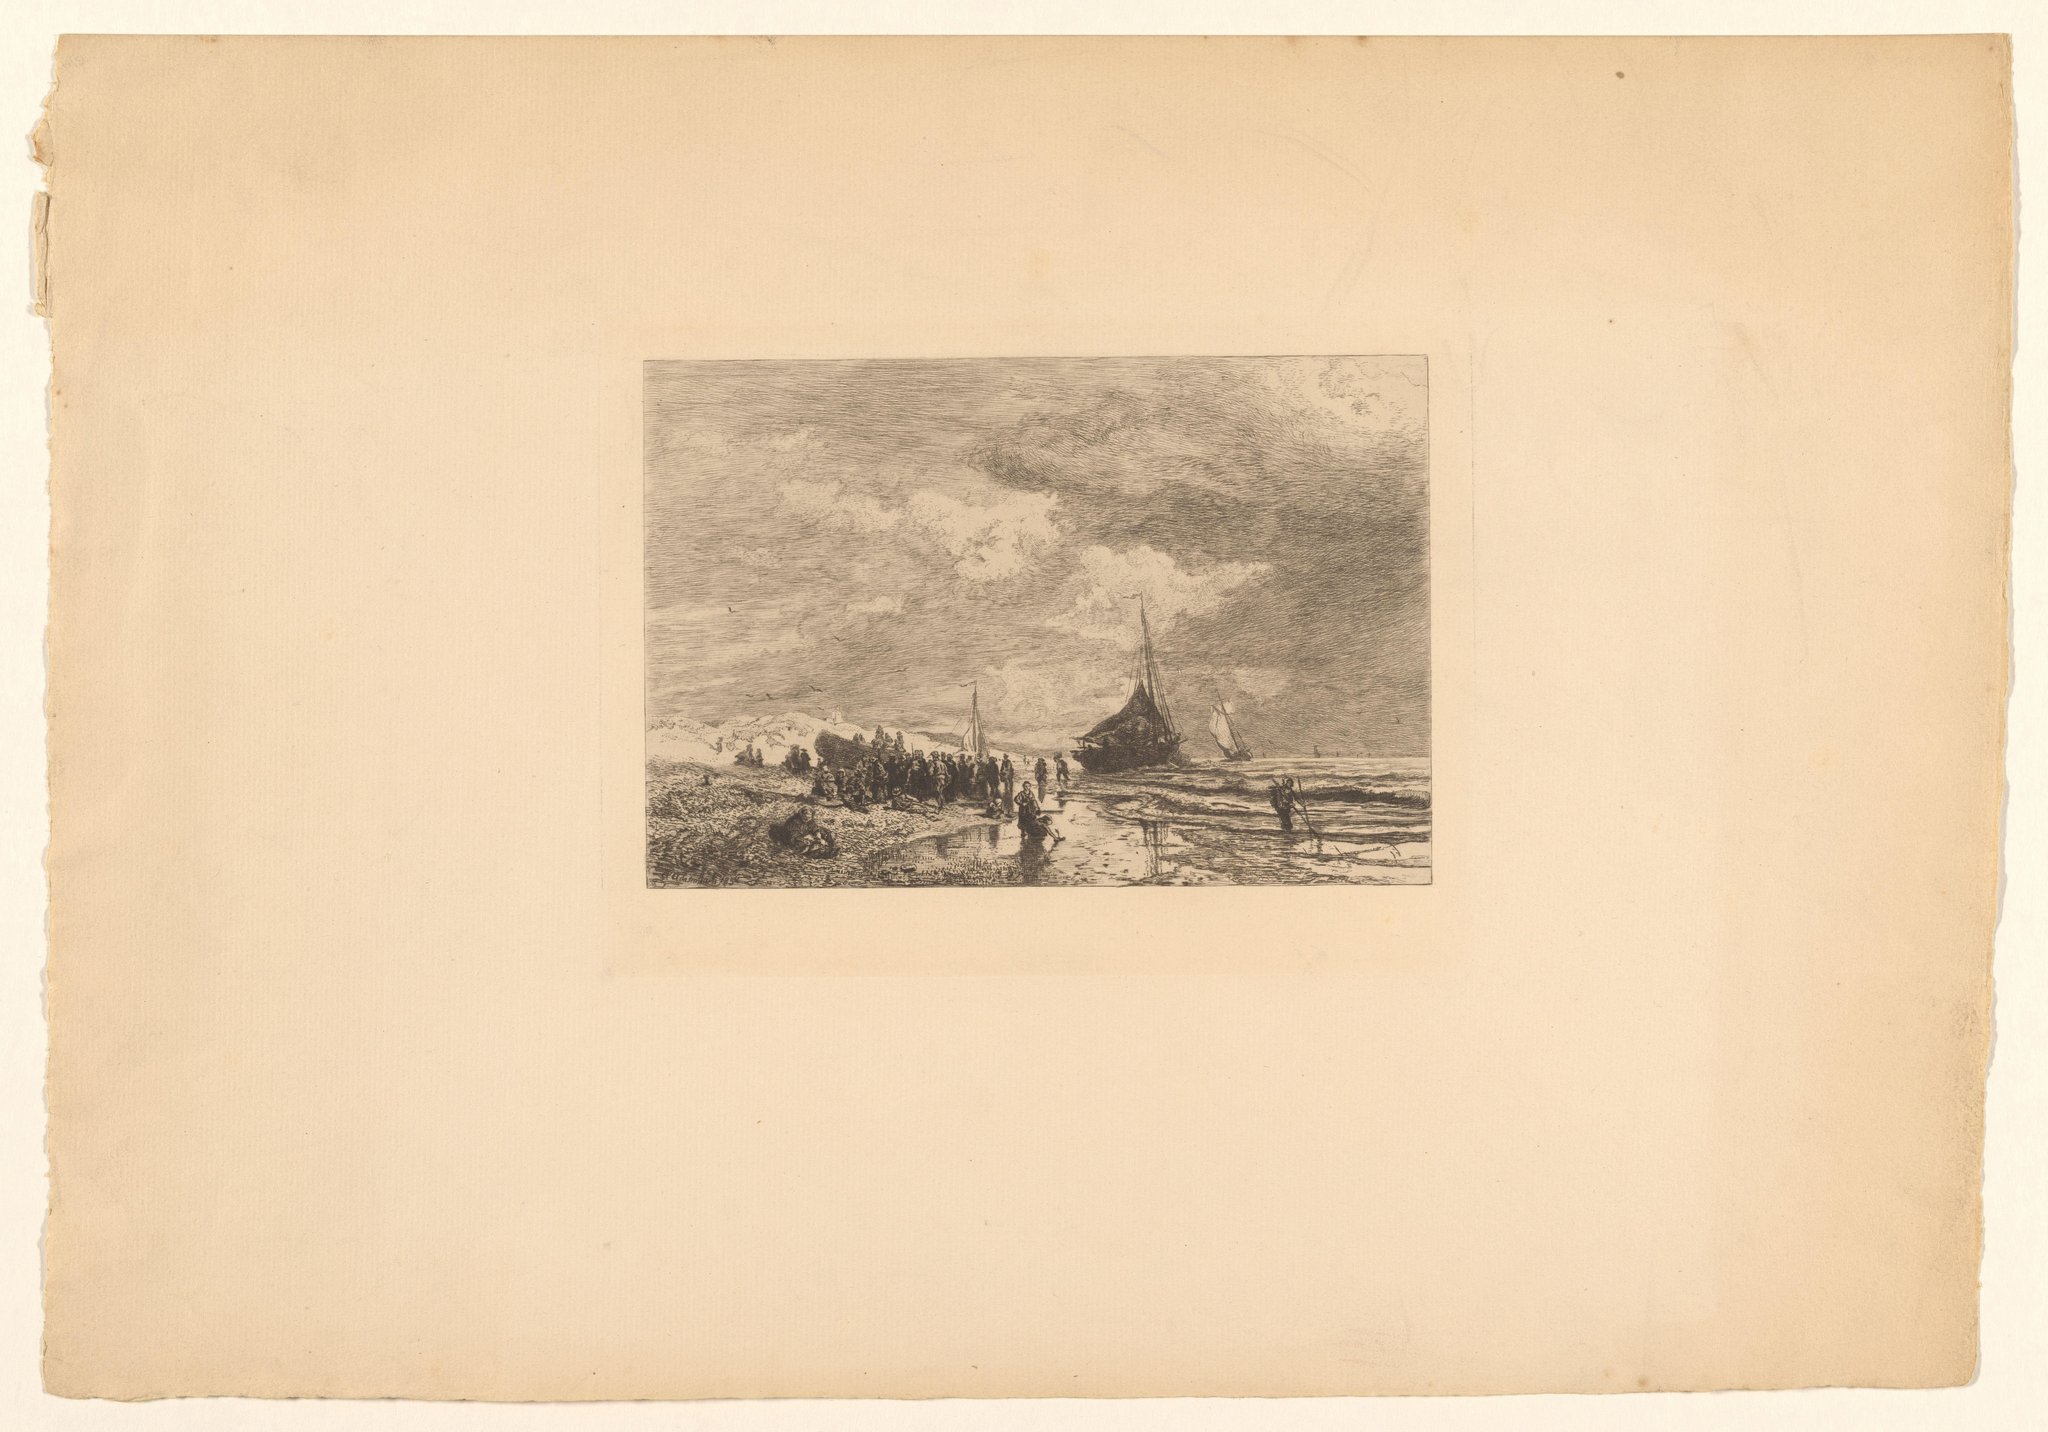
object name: print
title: Plage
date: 1863-1880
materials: paper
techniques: etching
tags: ebb, low tide, beach, sea and coastal fishery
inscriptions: collector's mark: Lugt 2228